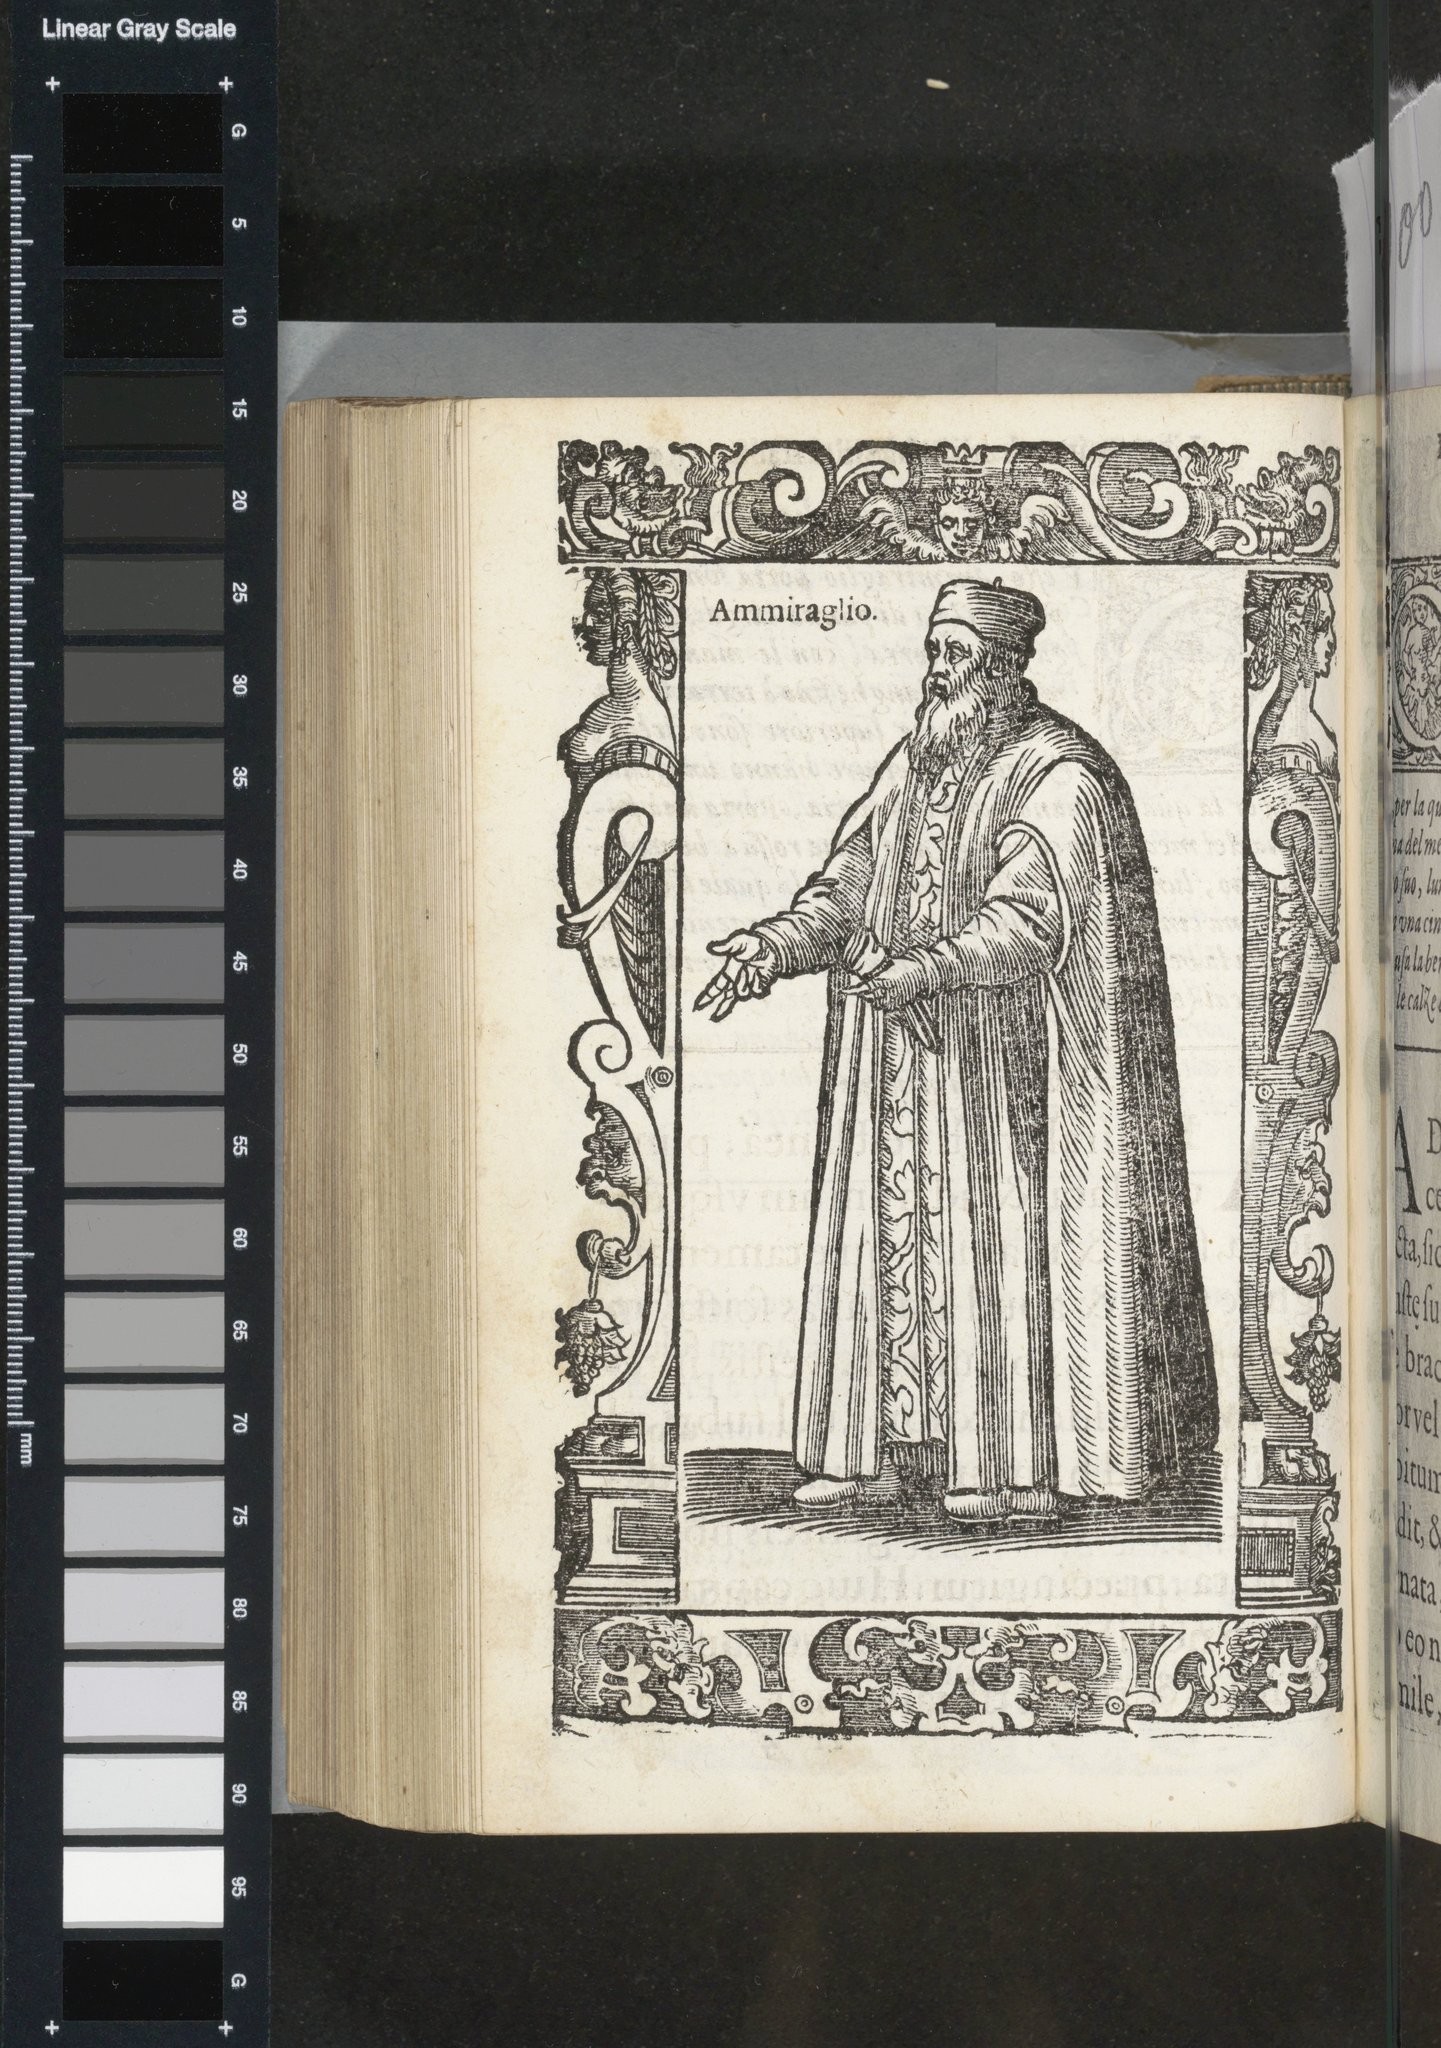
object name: costume print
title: Habiti antichi, et moderni di tutto il mondo..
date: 1598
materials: paper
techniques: woodcut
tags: fashion plates